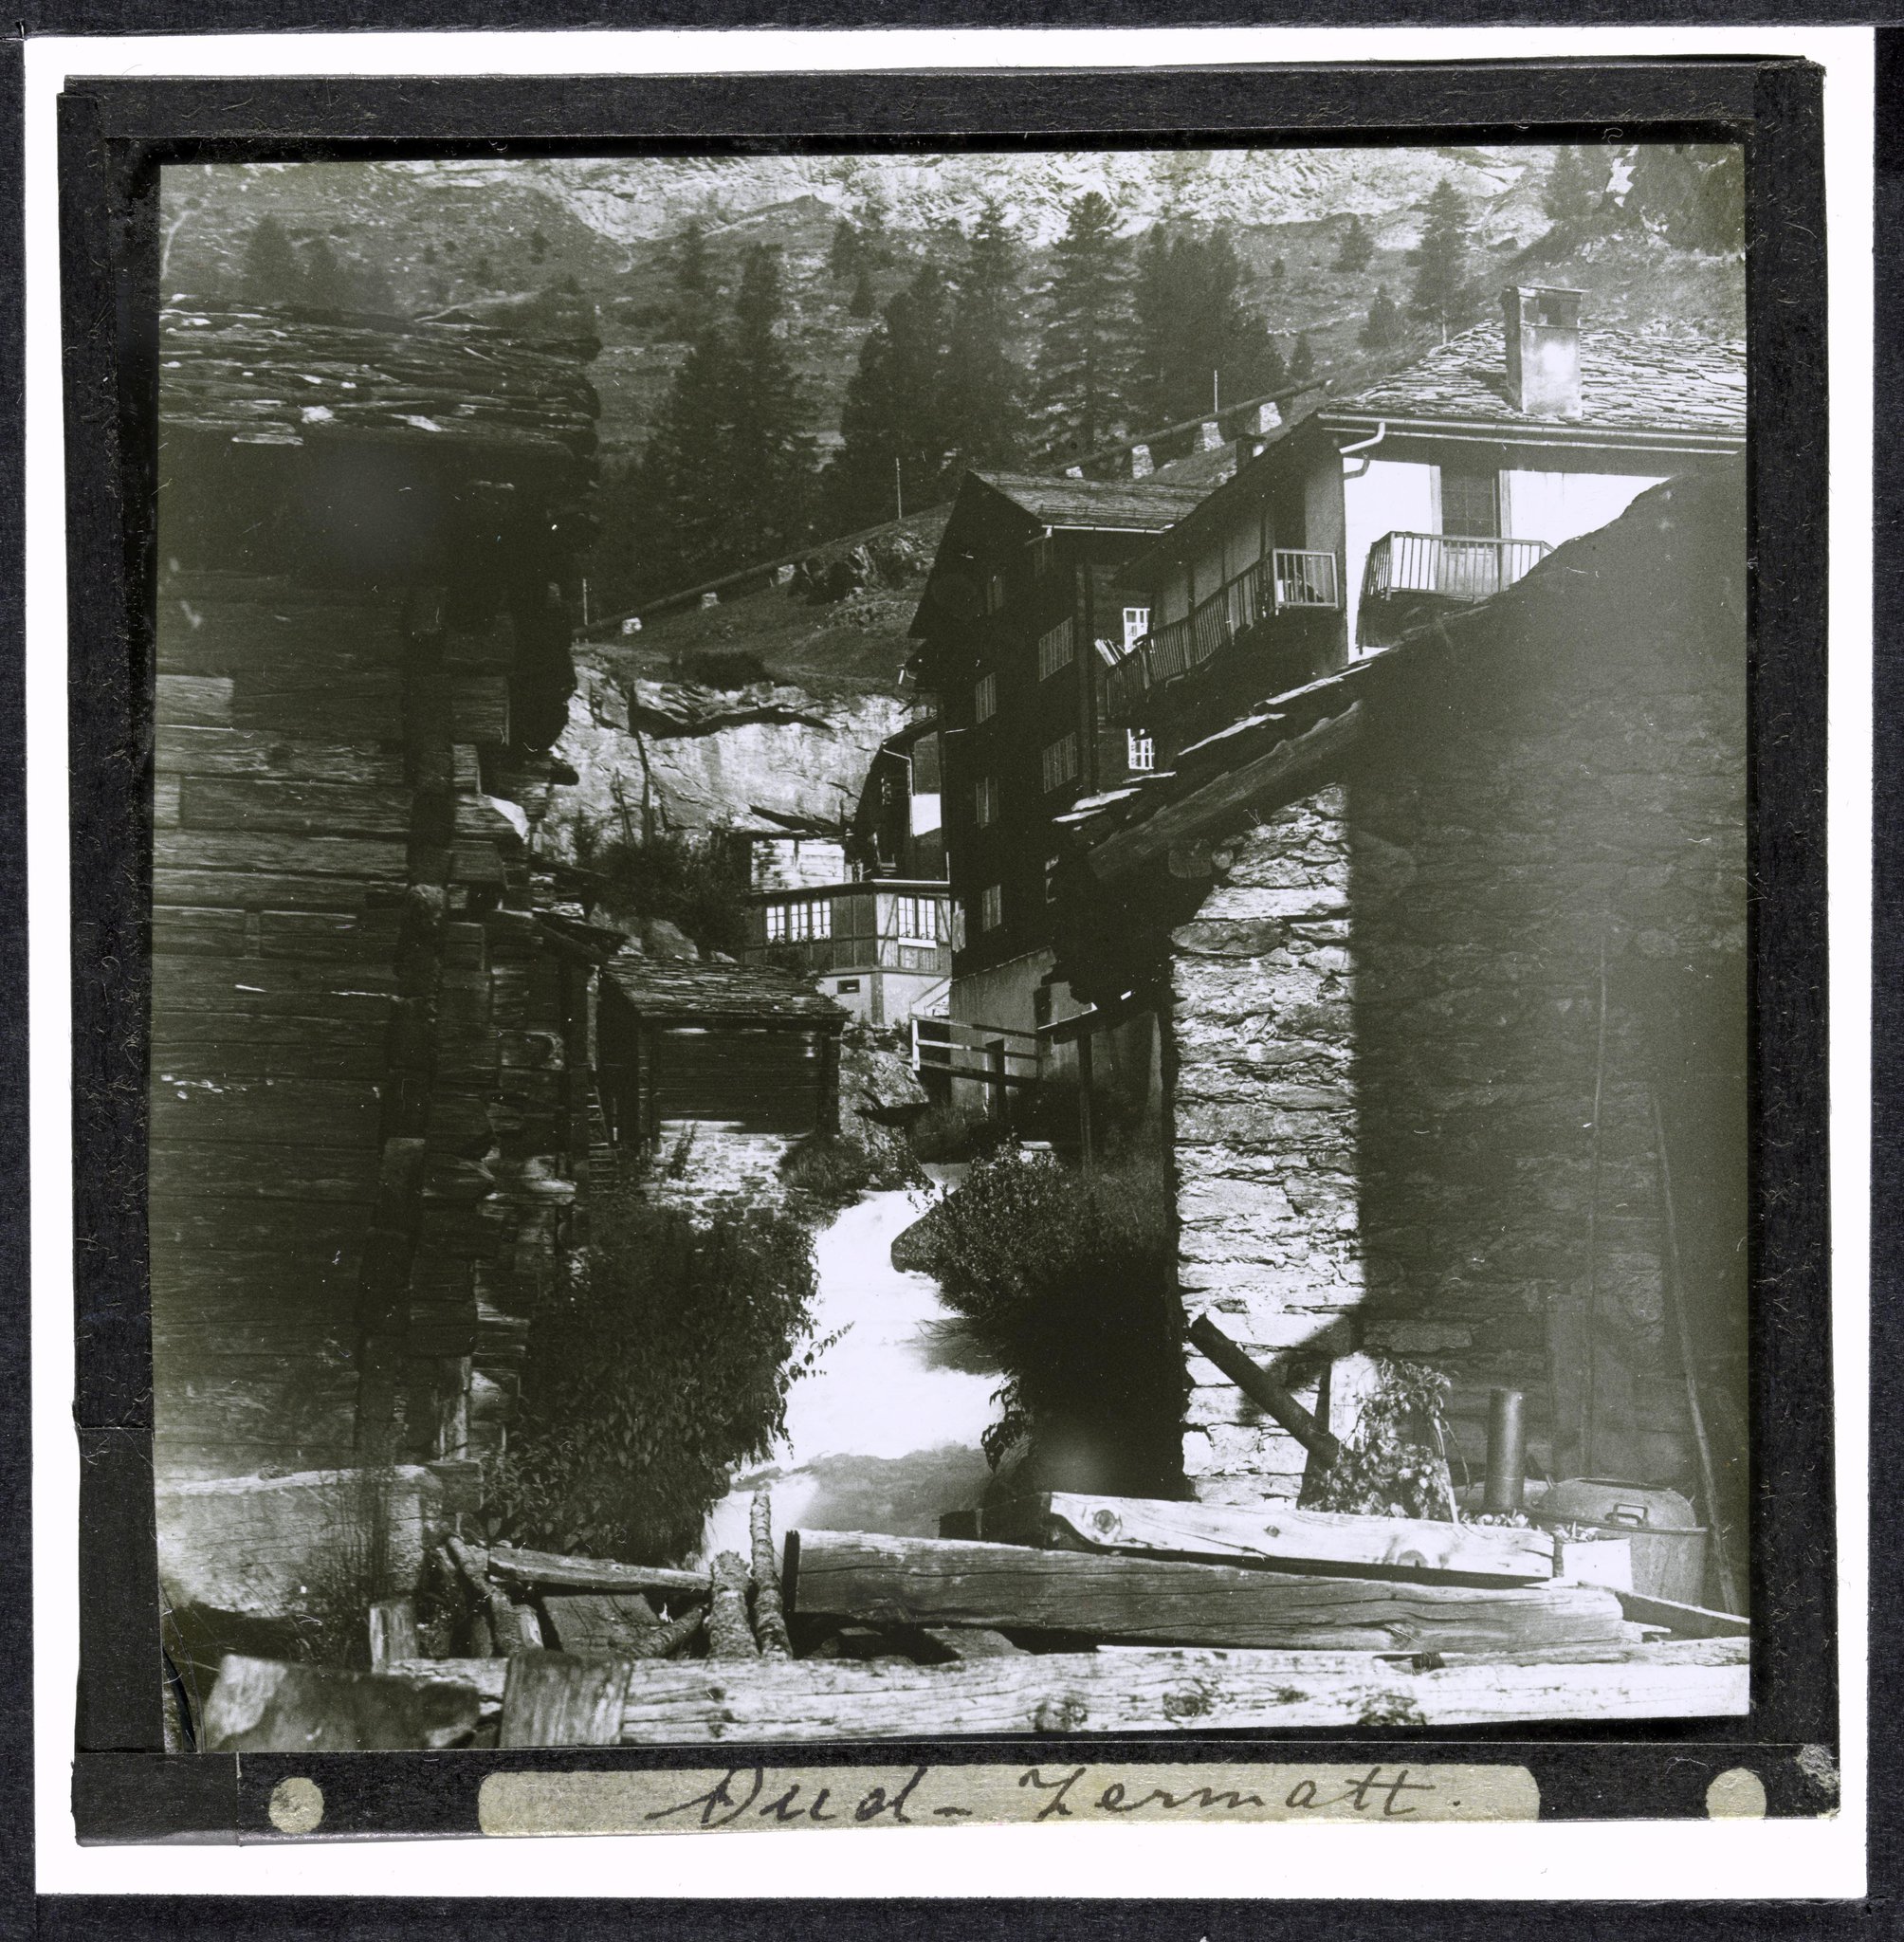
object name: glasdia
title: Oud-Zermatt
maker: Anonymous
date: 1907-1935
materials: glass, ink, paper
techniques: slide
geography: zermatt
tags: city-view, and landscape with man-made constructions